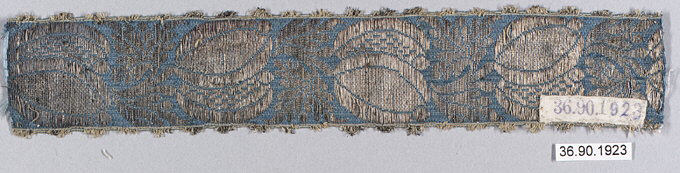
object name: galloon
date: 1767-1833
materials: metal thread, silk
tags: flowers